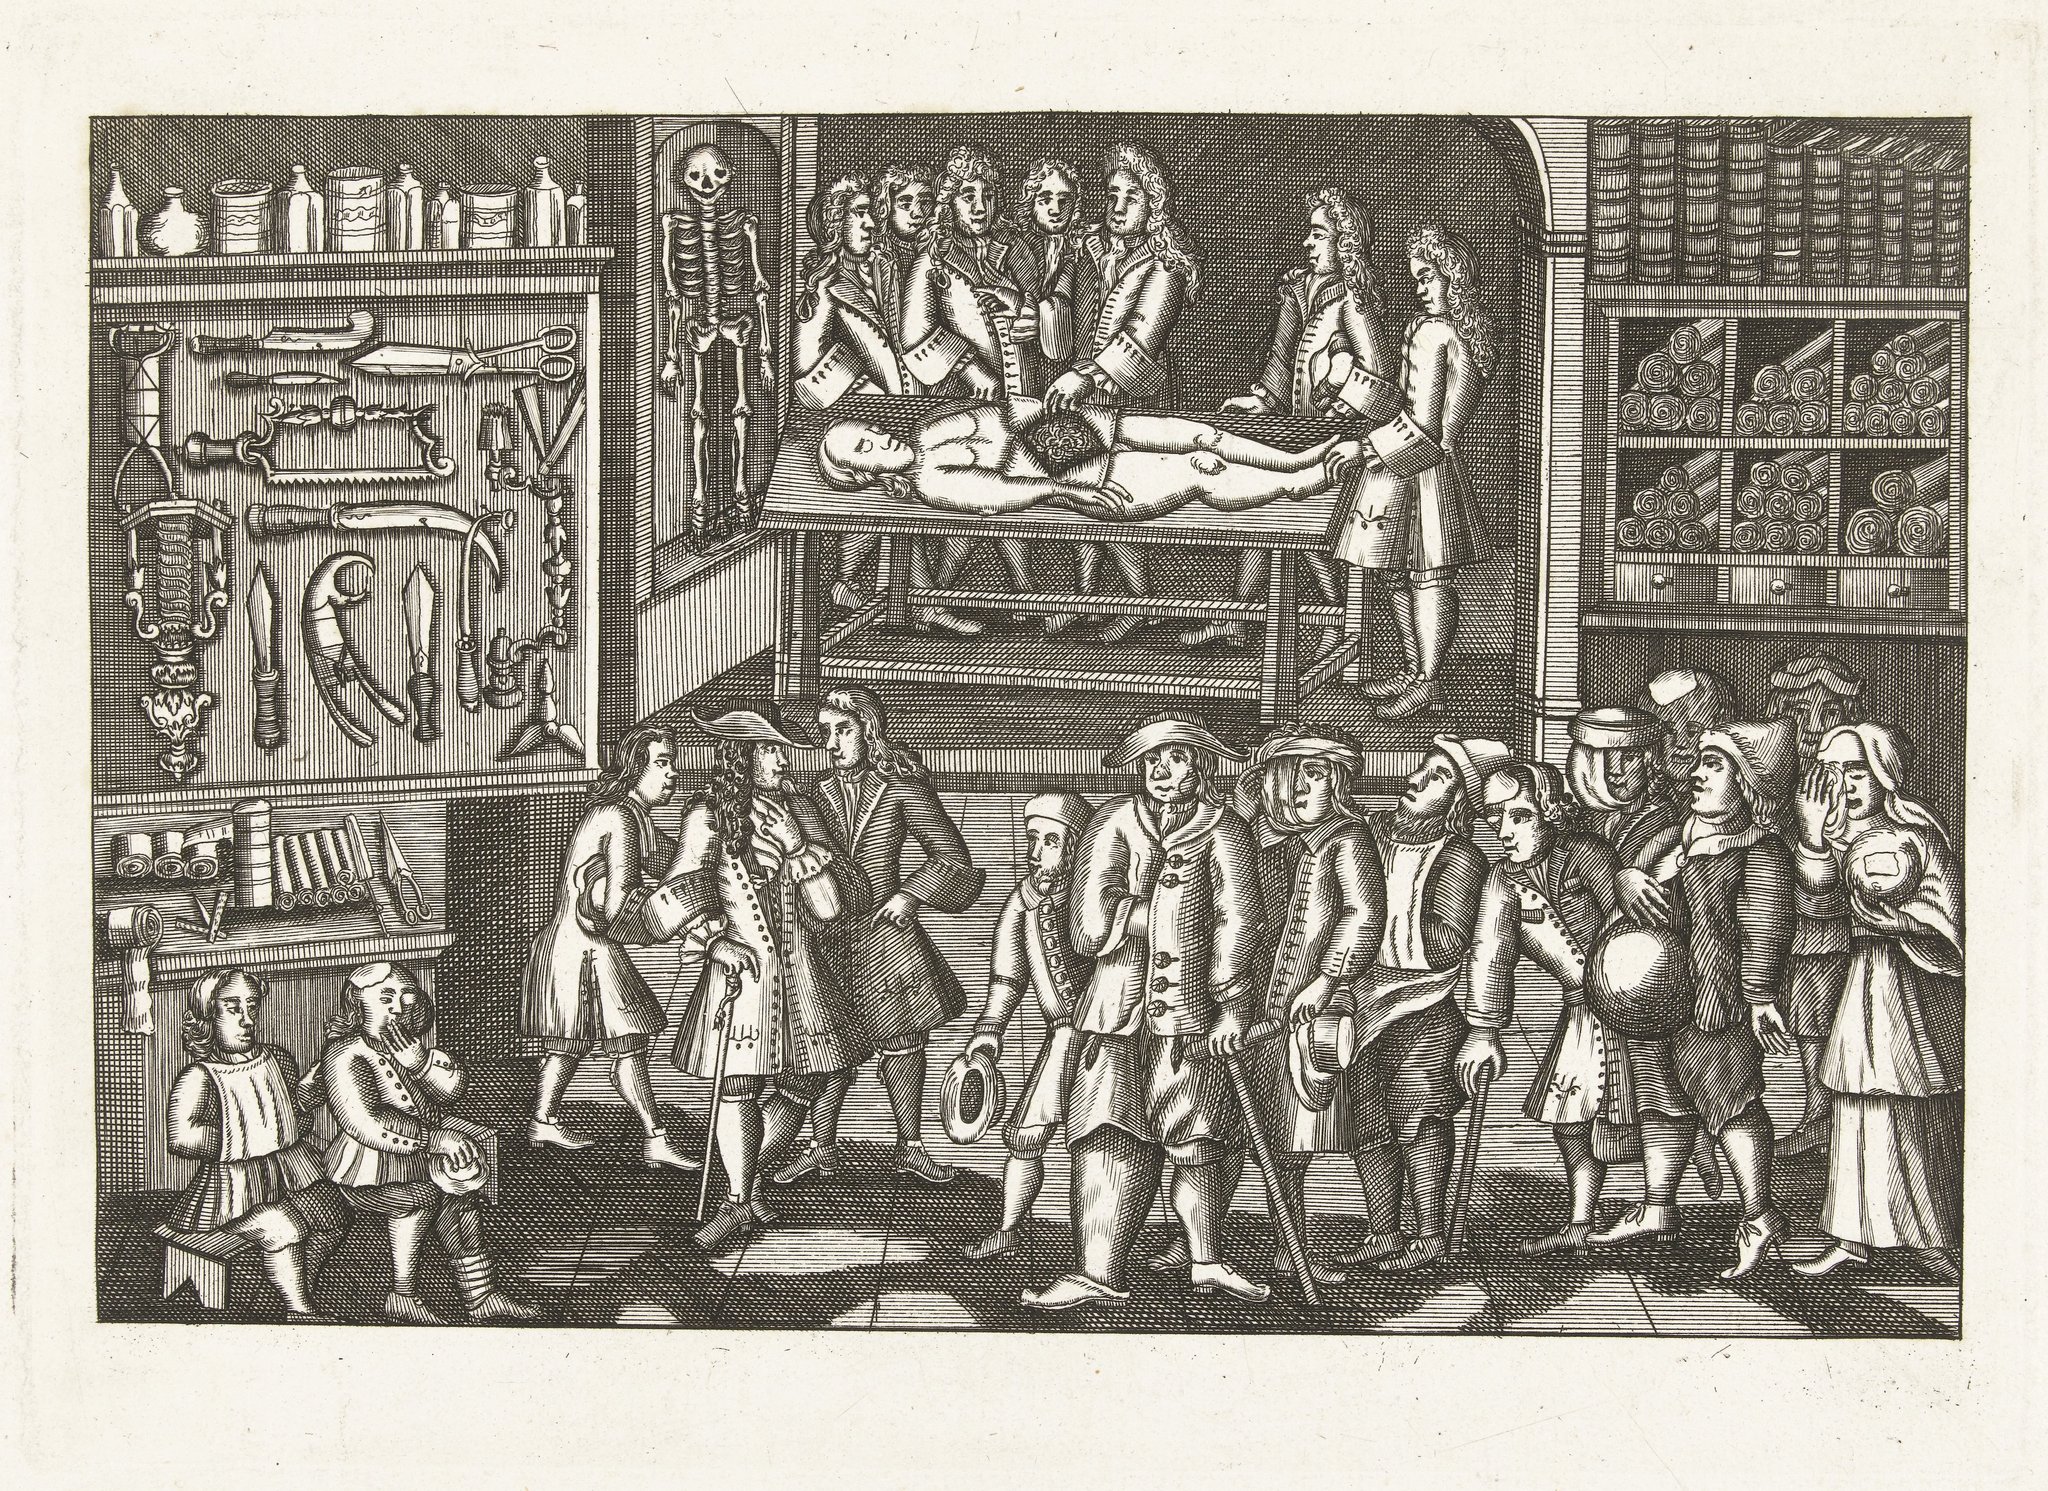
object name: print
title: De werkplaats van de Chirurgijnsgilde te Amsterdam, ca. 1725-1730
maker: Anonymous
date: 1725-1727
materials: paper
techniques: engraving, etching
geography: northern netherlands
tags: dissection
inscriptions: collector's mark: Lugt 2228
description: Gezicht in de werkplaats van de Chirurgijnsgilde te Amsterdam, ca. 1725-1730. Op de voorgrond een stoet patienten bij een arts met twee assistenten, op de achtergrond een anatomische les. Links een uitstalling van alle chirurgische instrumenten, rechts een kast met boeken en opgerolde papieren.